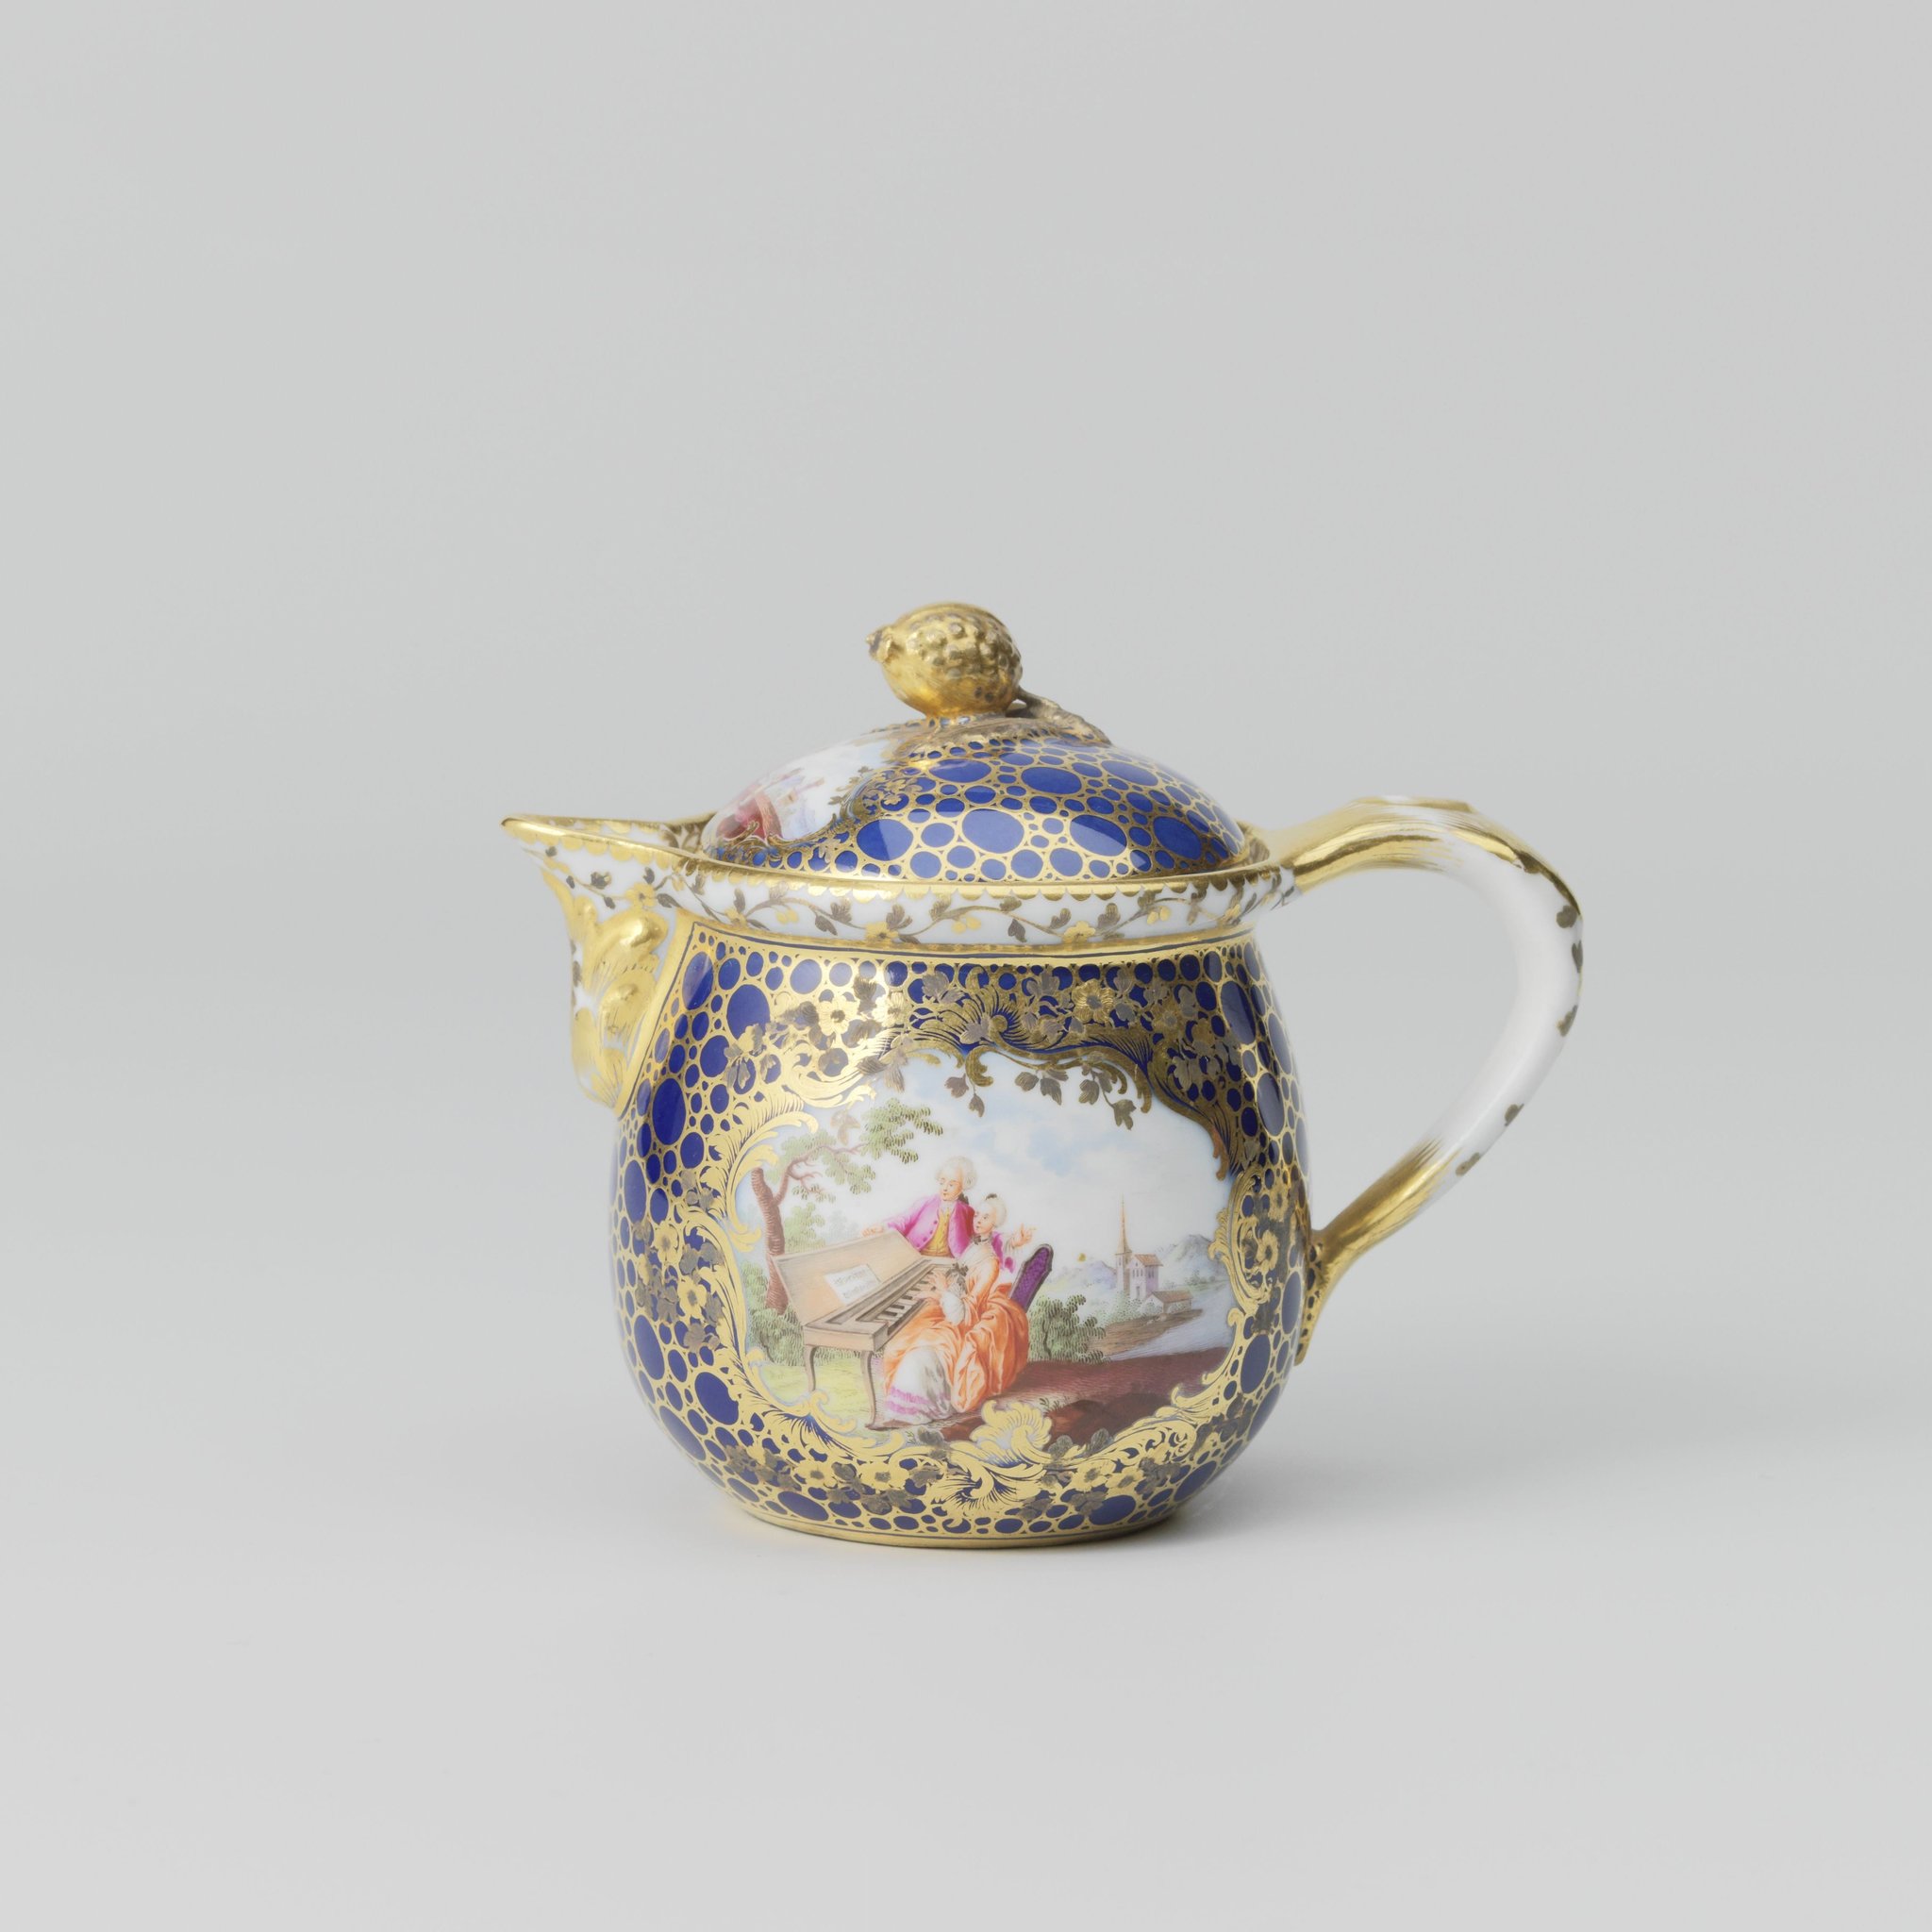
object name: milk jug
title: Milk jug with a couple in a landscape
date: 1765-1770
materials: glaze, gold, paint, porcelain, silver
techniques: firing, gilding, turning, vitrification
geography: vienna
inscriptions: mark: ‘schild/ N’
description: Melkkan van porselein, beschilderd op het glauur in emailkleuren, zilver[?] en goud. De kan is bedekt met blauw waarover in goud een patroon van cirkels is aangebracht. Hierin uitgespaard tweemaal een rocaille cartouche met daarin een paar in een landschap, de vrouw spelend op een luit of klavecimbel terwijl de man toekijkt of de muziek vashoudt. Het oor, de tuit en de buiten- en binnenrand met bloemranken. De deksel met dezelfde decoratie, maar nu een voorstelling van de dame die een hond aan het trainen is; dekselknop in de vorm van een granaatappel. Aan de binnenzijde een bloemtak. Gemerkt op de onderzijde met een vervaagd schild en de letter N.